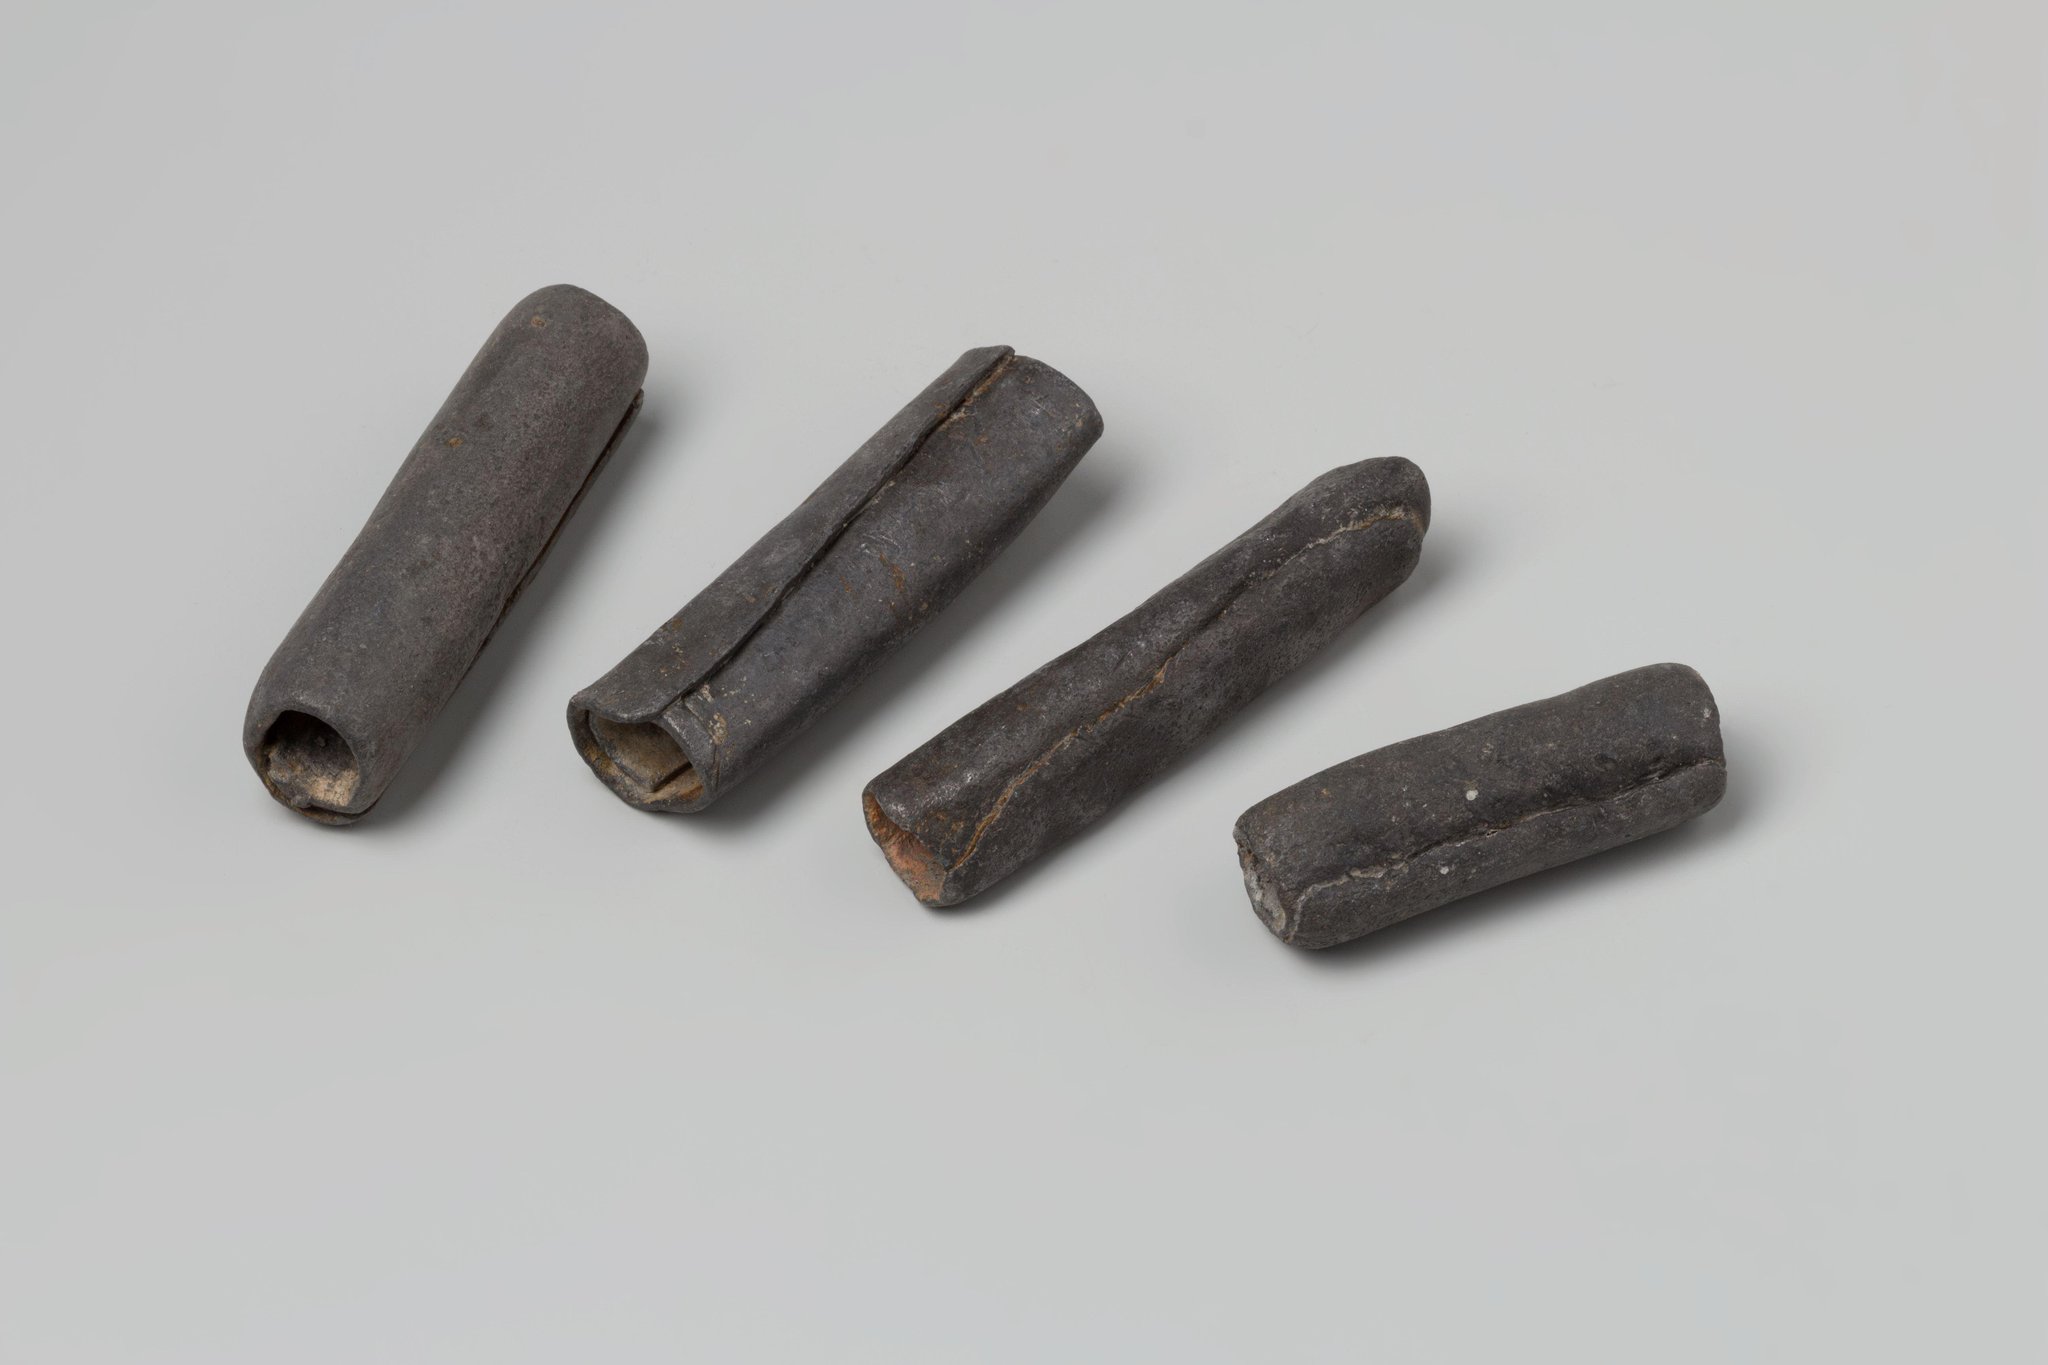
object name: lead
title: Loden rol uit het wrak van de Oost-Indiëvaarder 't Vliegend Hart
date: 1700-1735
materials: lead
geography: middelburg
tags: 't vliegend hart (schip), verenigde oostindische compagnie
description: Deze loden buisjes zijn vermoedelijk afkomstig van visnetten ofwel op TVliegend Hart zelf ofwel van vissers die hun netten aan het wrak verloren.